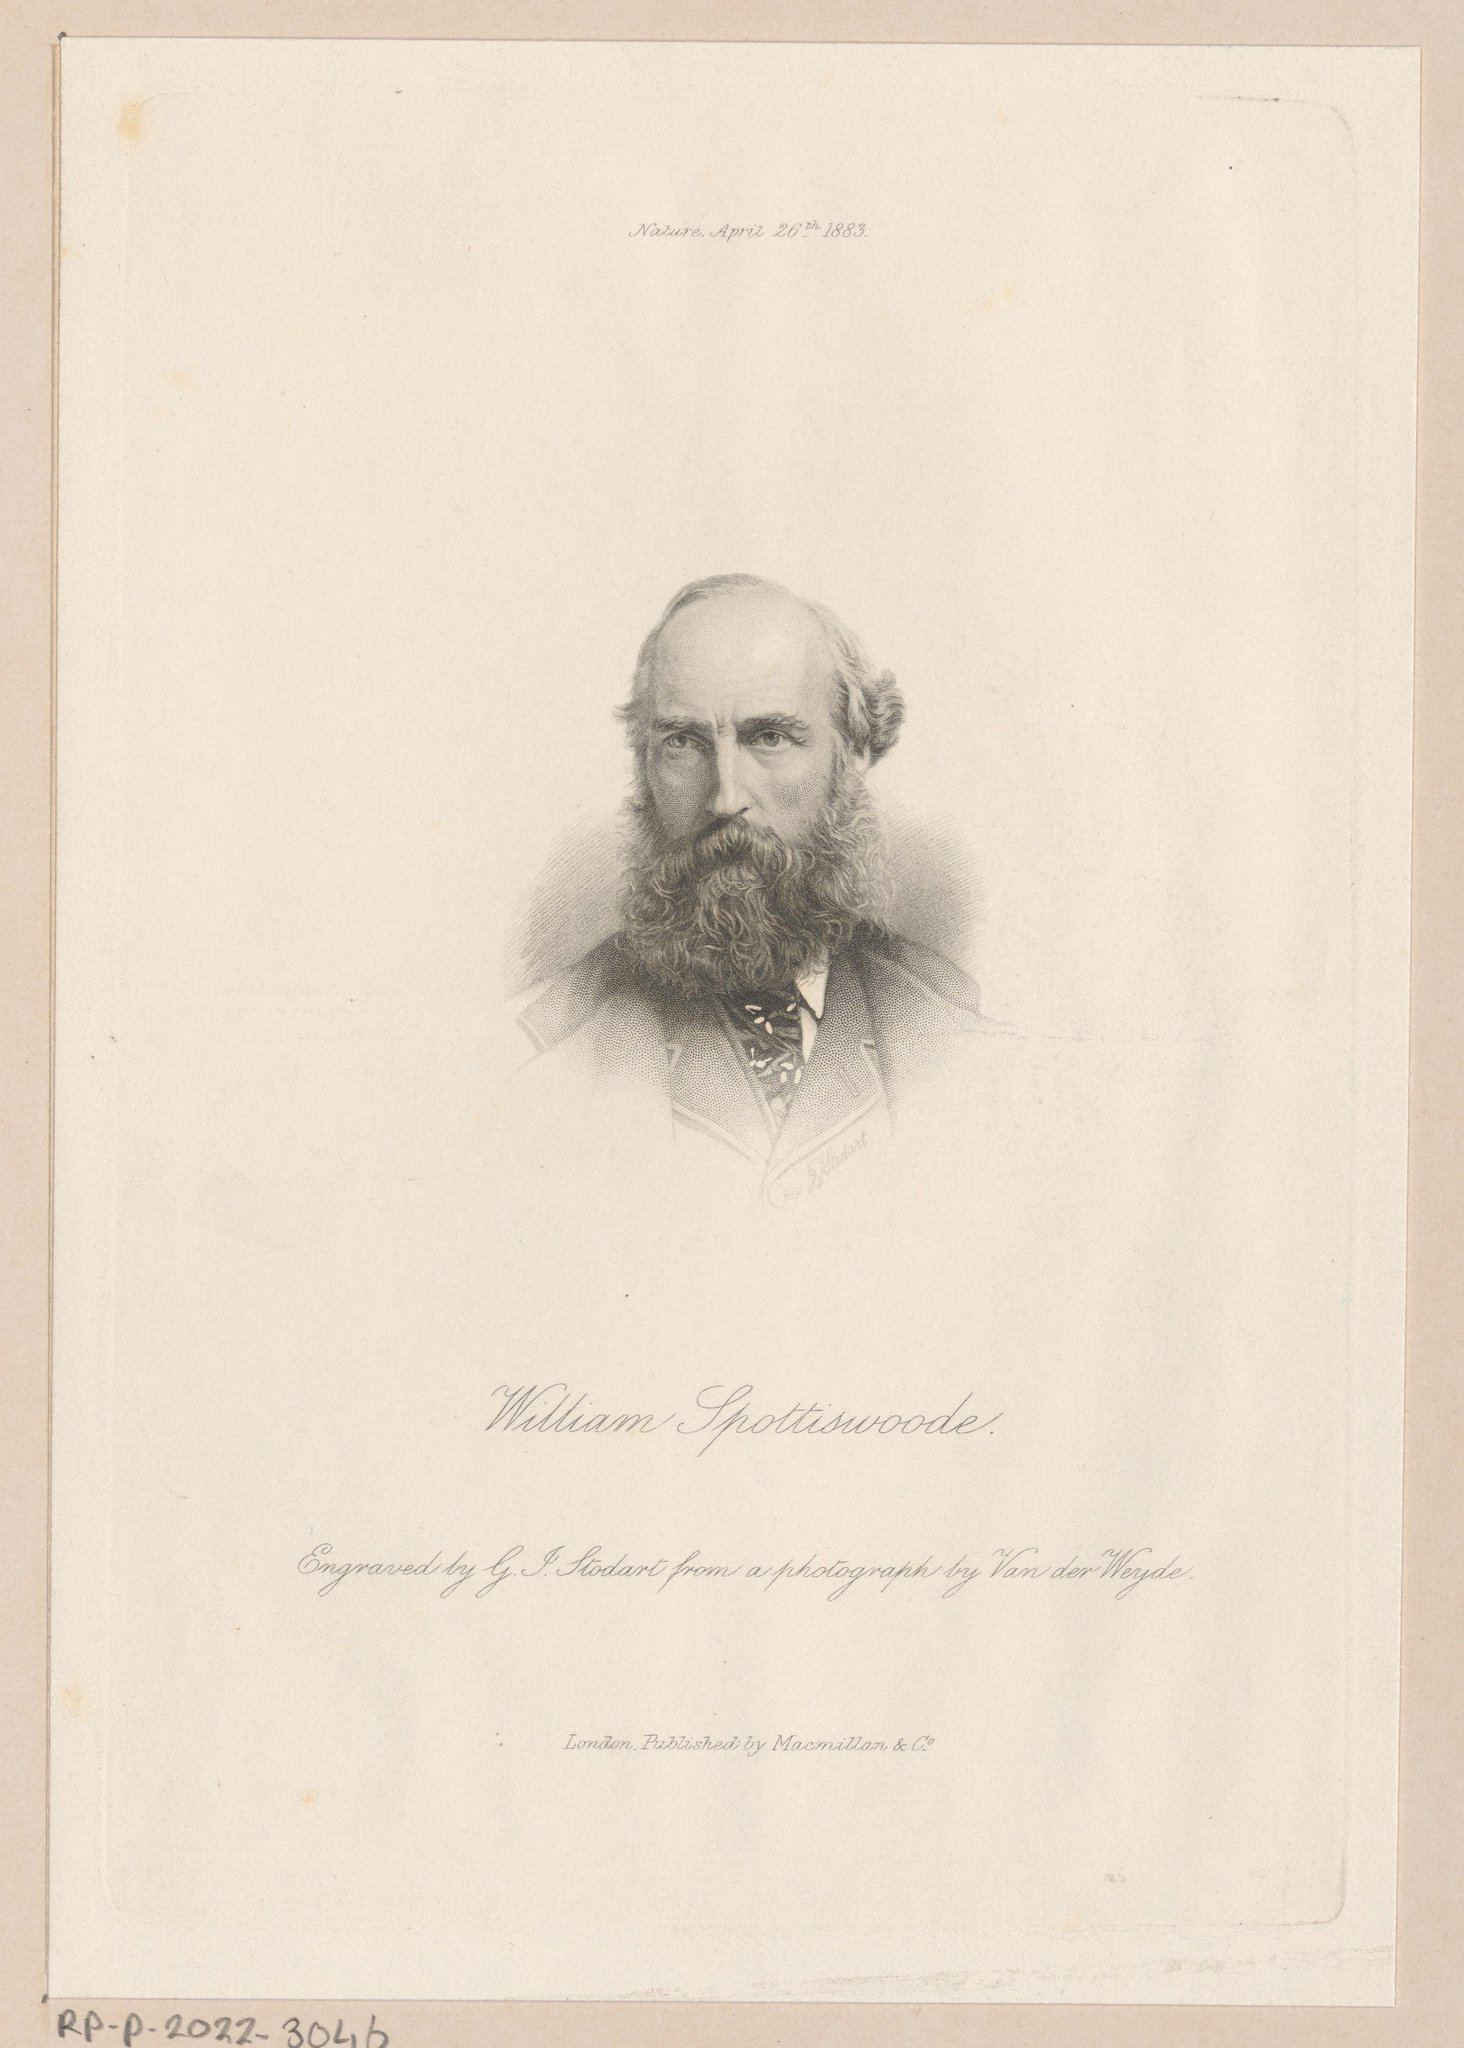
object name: print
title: Portret van William Spottiswoode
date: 1883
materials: paper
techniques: engraving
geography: london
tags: london, physicist, historical persons, mathematics (+ portrait of scholar, scientist)